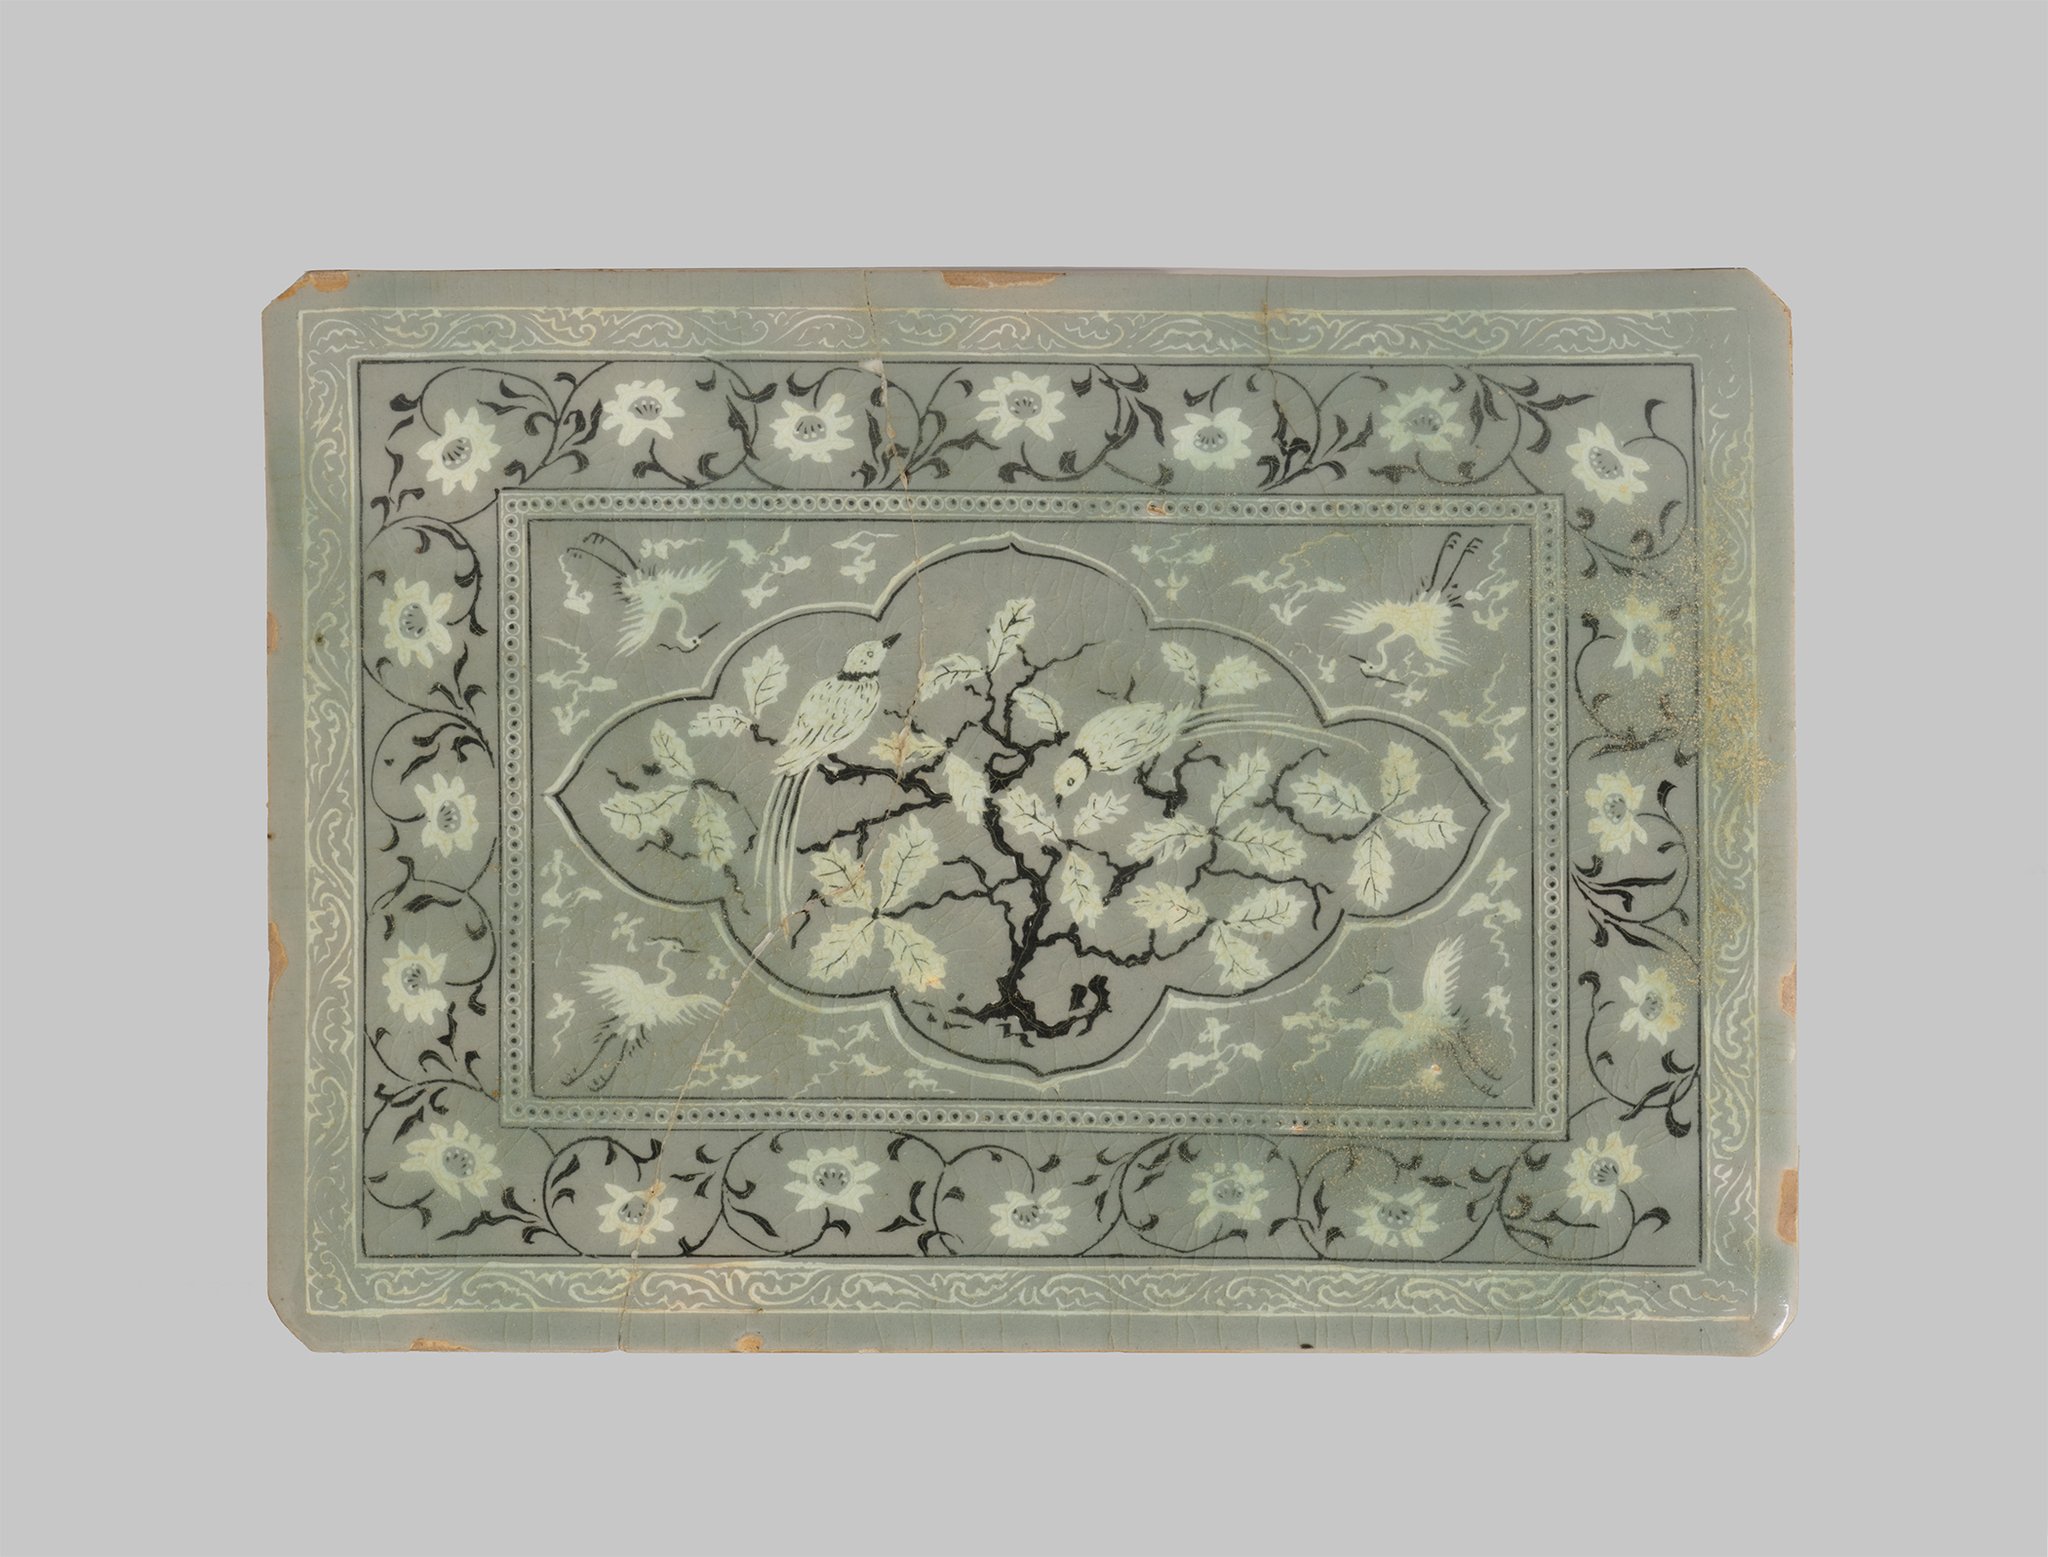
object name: tile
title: Tile decorated with birds and flowers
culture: korean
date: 1201-1300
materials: ceramic glaze, glaze, stoneware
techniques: inlay